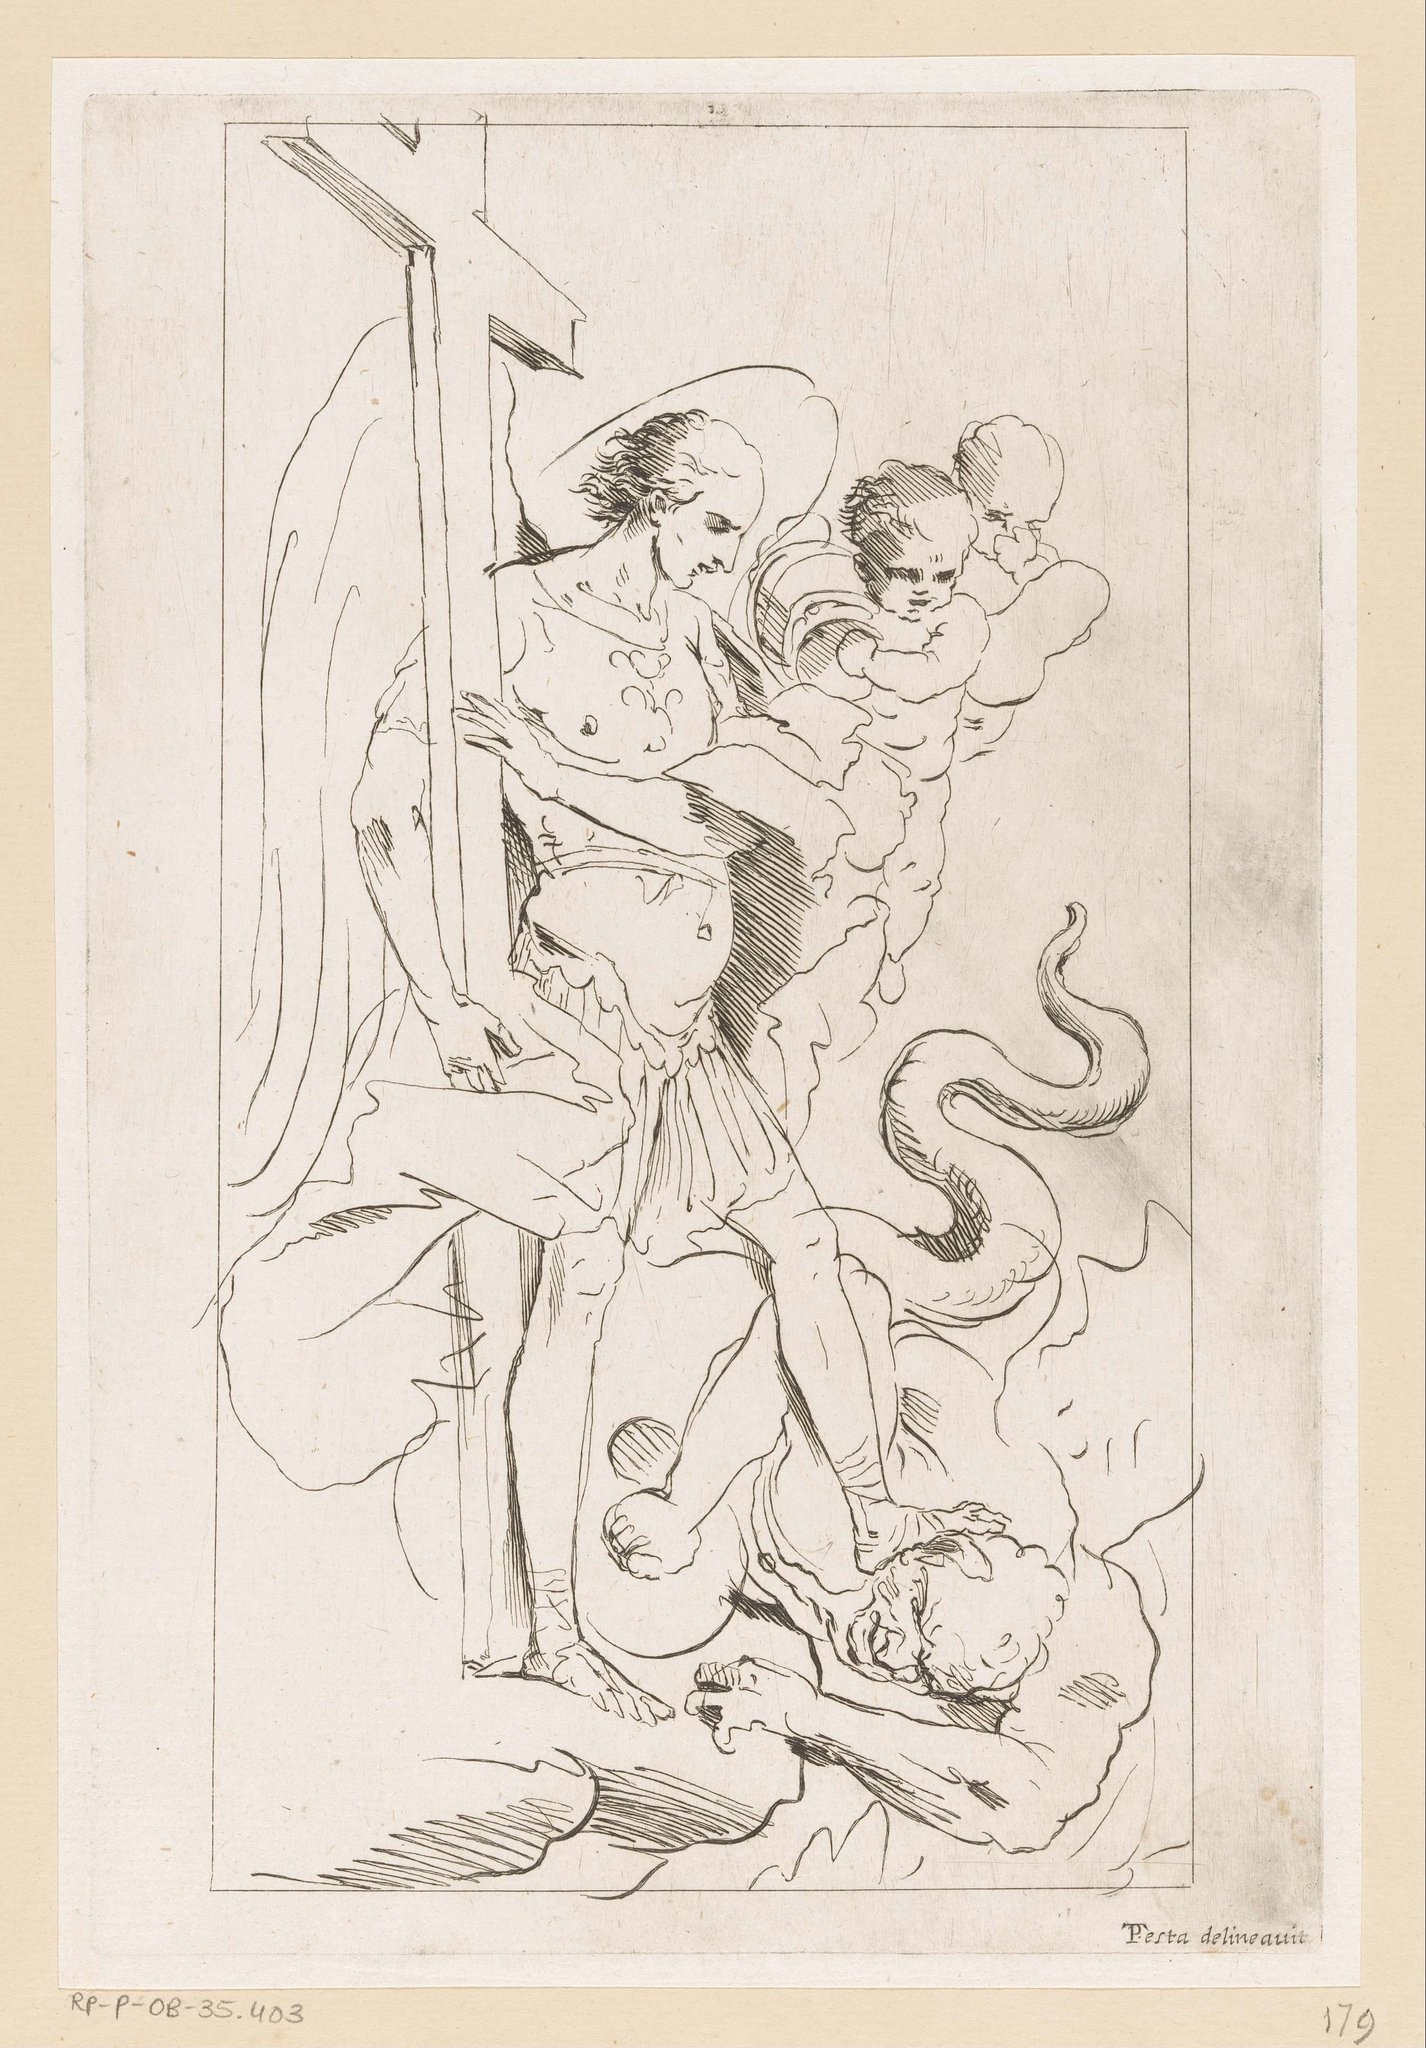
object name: print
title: Aartsengel Michaël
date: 1650-1750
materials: paper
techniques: etching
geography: italy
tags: the archangel michael fighting the dragon (devil, satan)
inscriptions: collector's mark: Lugt 240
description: De aartsengel Michaël met een groot kruis vertrapt een monsterlijk wezen, half duivel half slang.